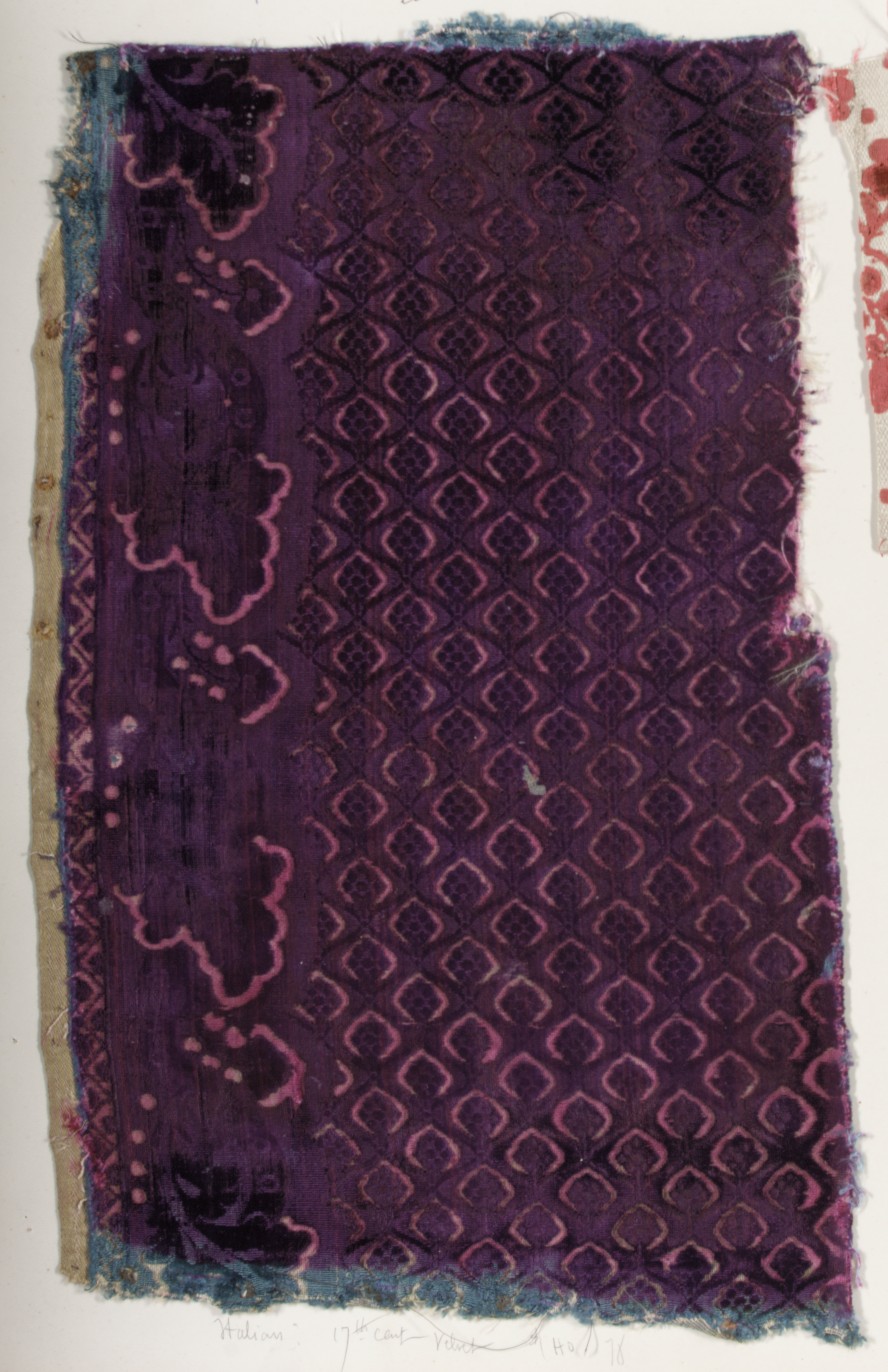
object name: fragment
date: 1601-1800